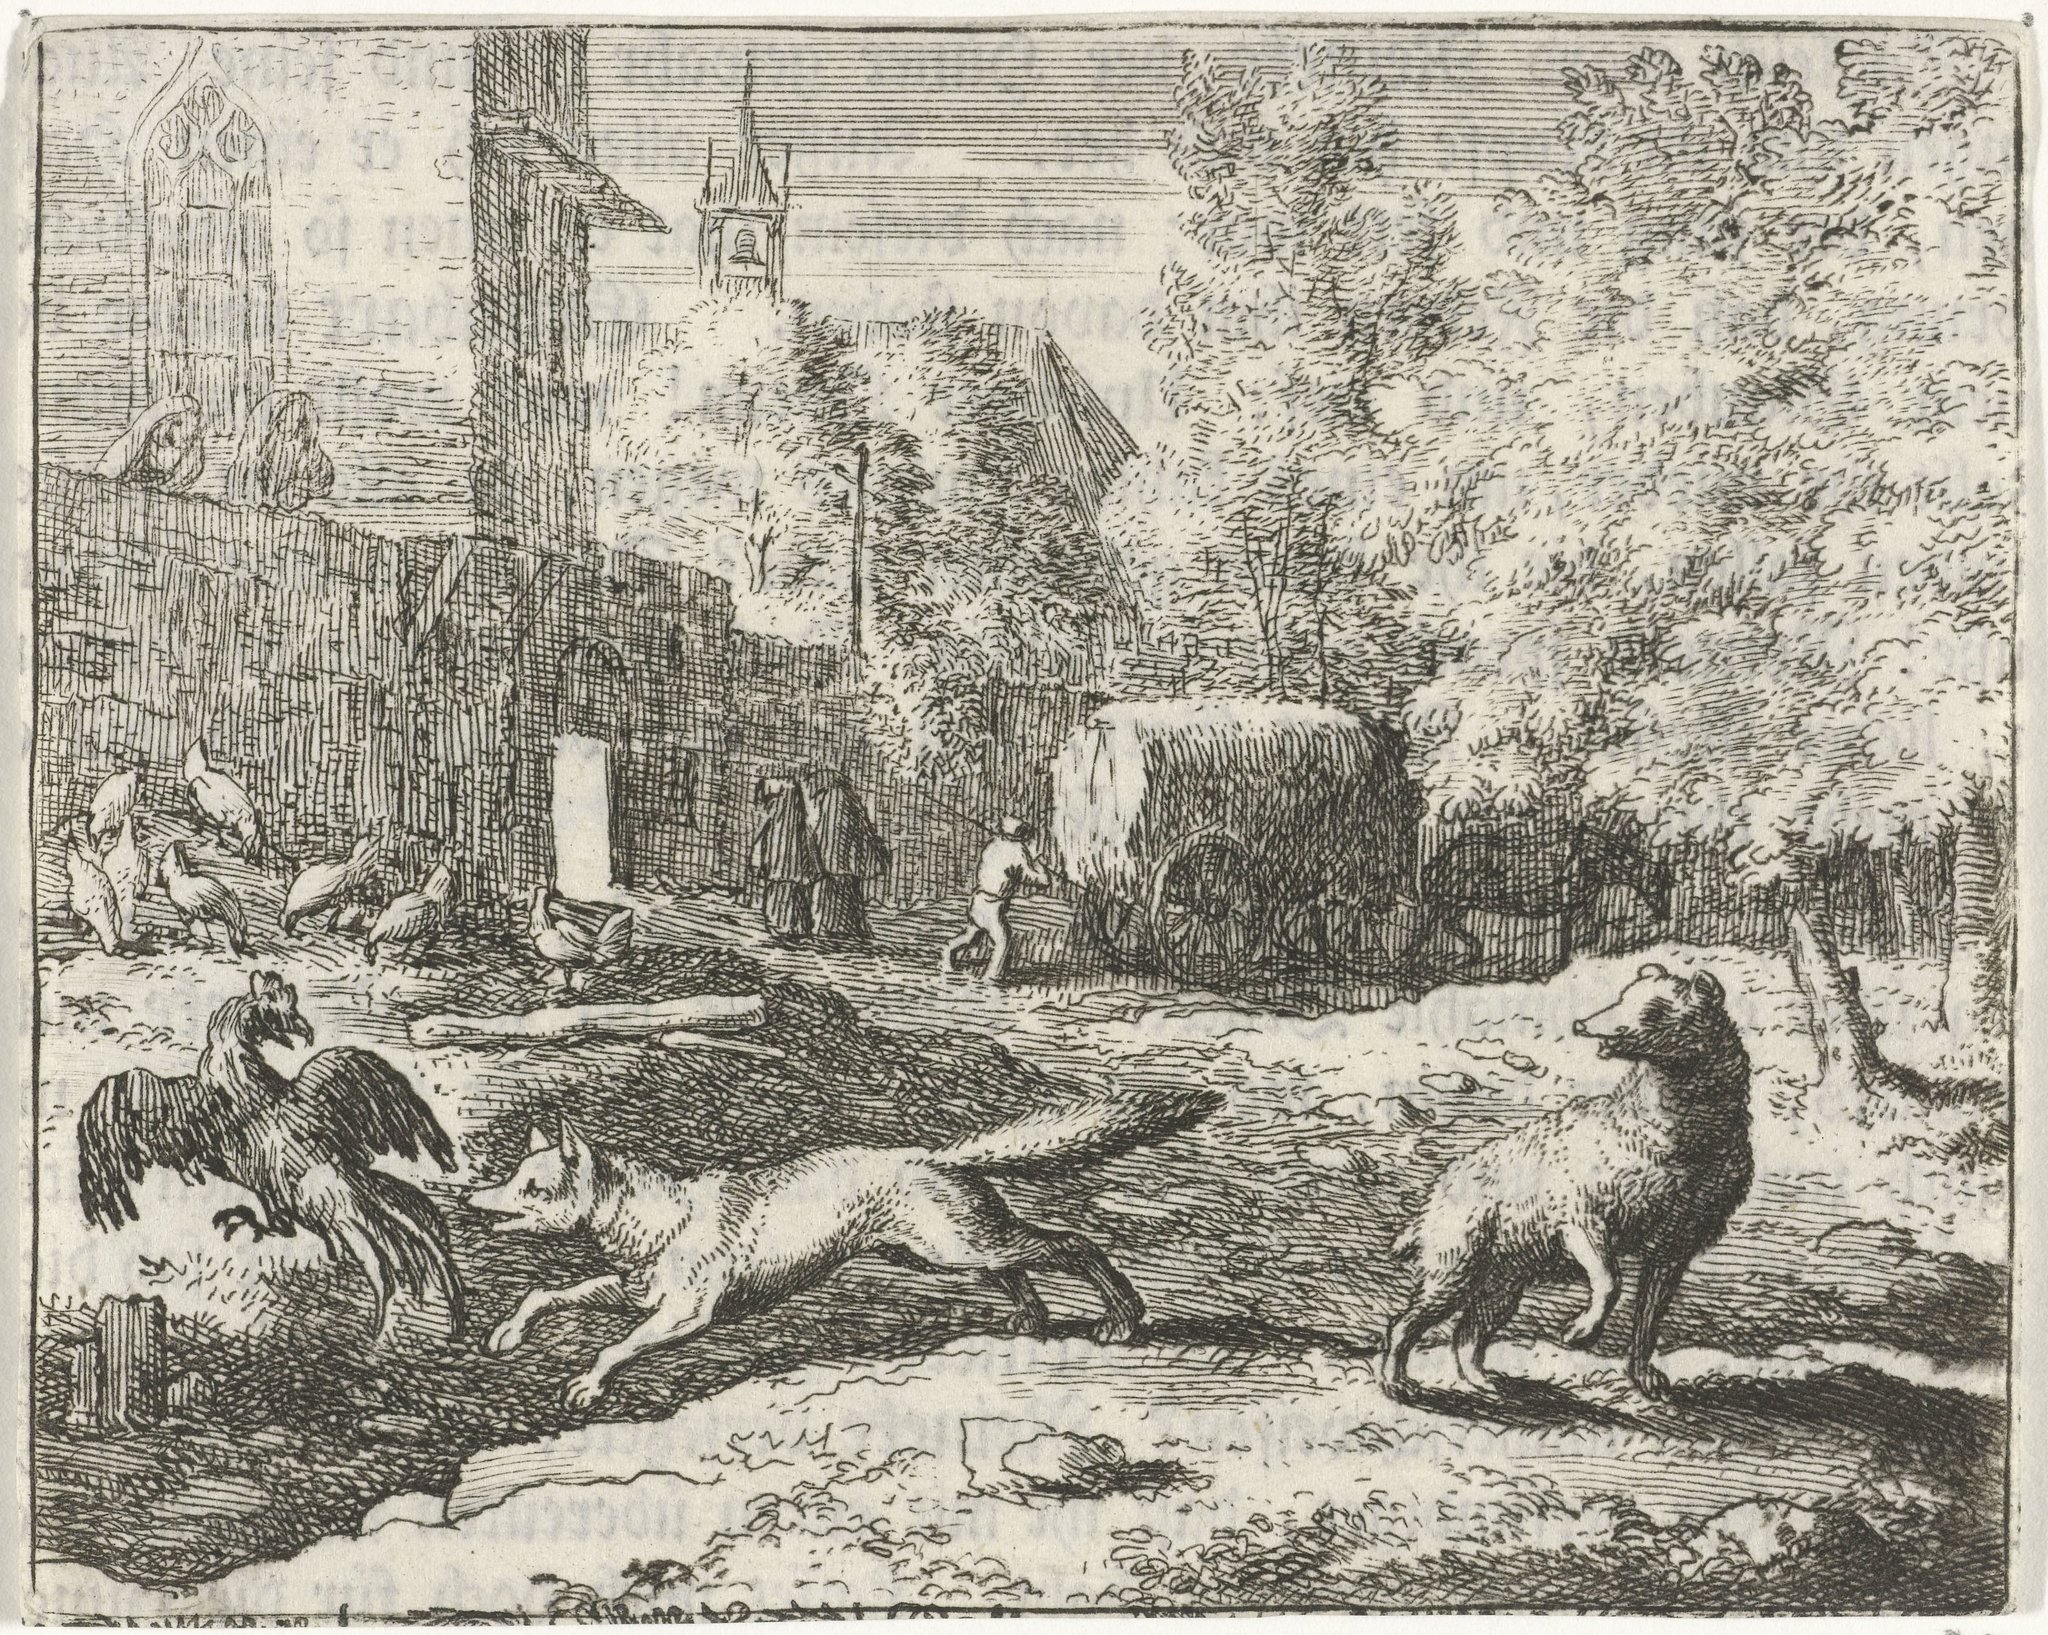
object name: book illustration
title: Reinaert de vos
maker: allaert van everdingen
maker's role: draughtsman, painter, print maker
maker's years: 1621-1675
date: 1665-1675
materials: paper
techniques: etching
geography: netherlands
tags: fable of reynard the fox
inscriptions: collector's mark: Lugt 2228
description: Isengrijn de wolf kijkt naar Reinaert de vos die achter een haan aan zit. Op de achterkant van de prent een Duits tekstfragment uit het verhaal van Reinaert de vos.